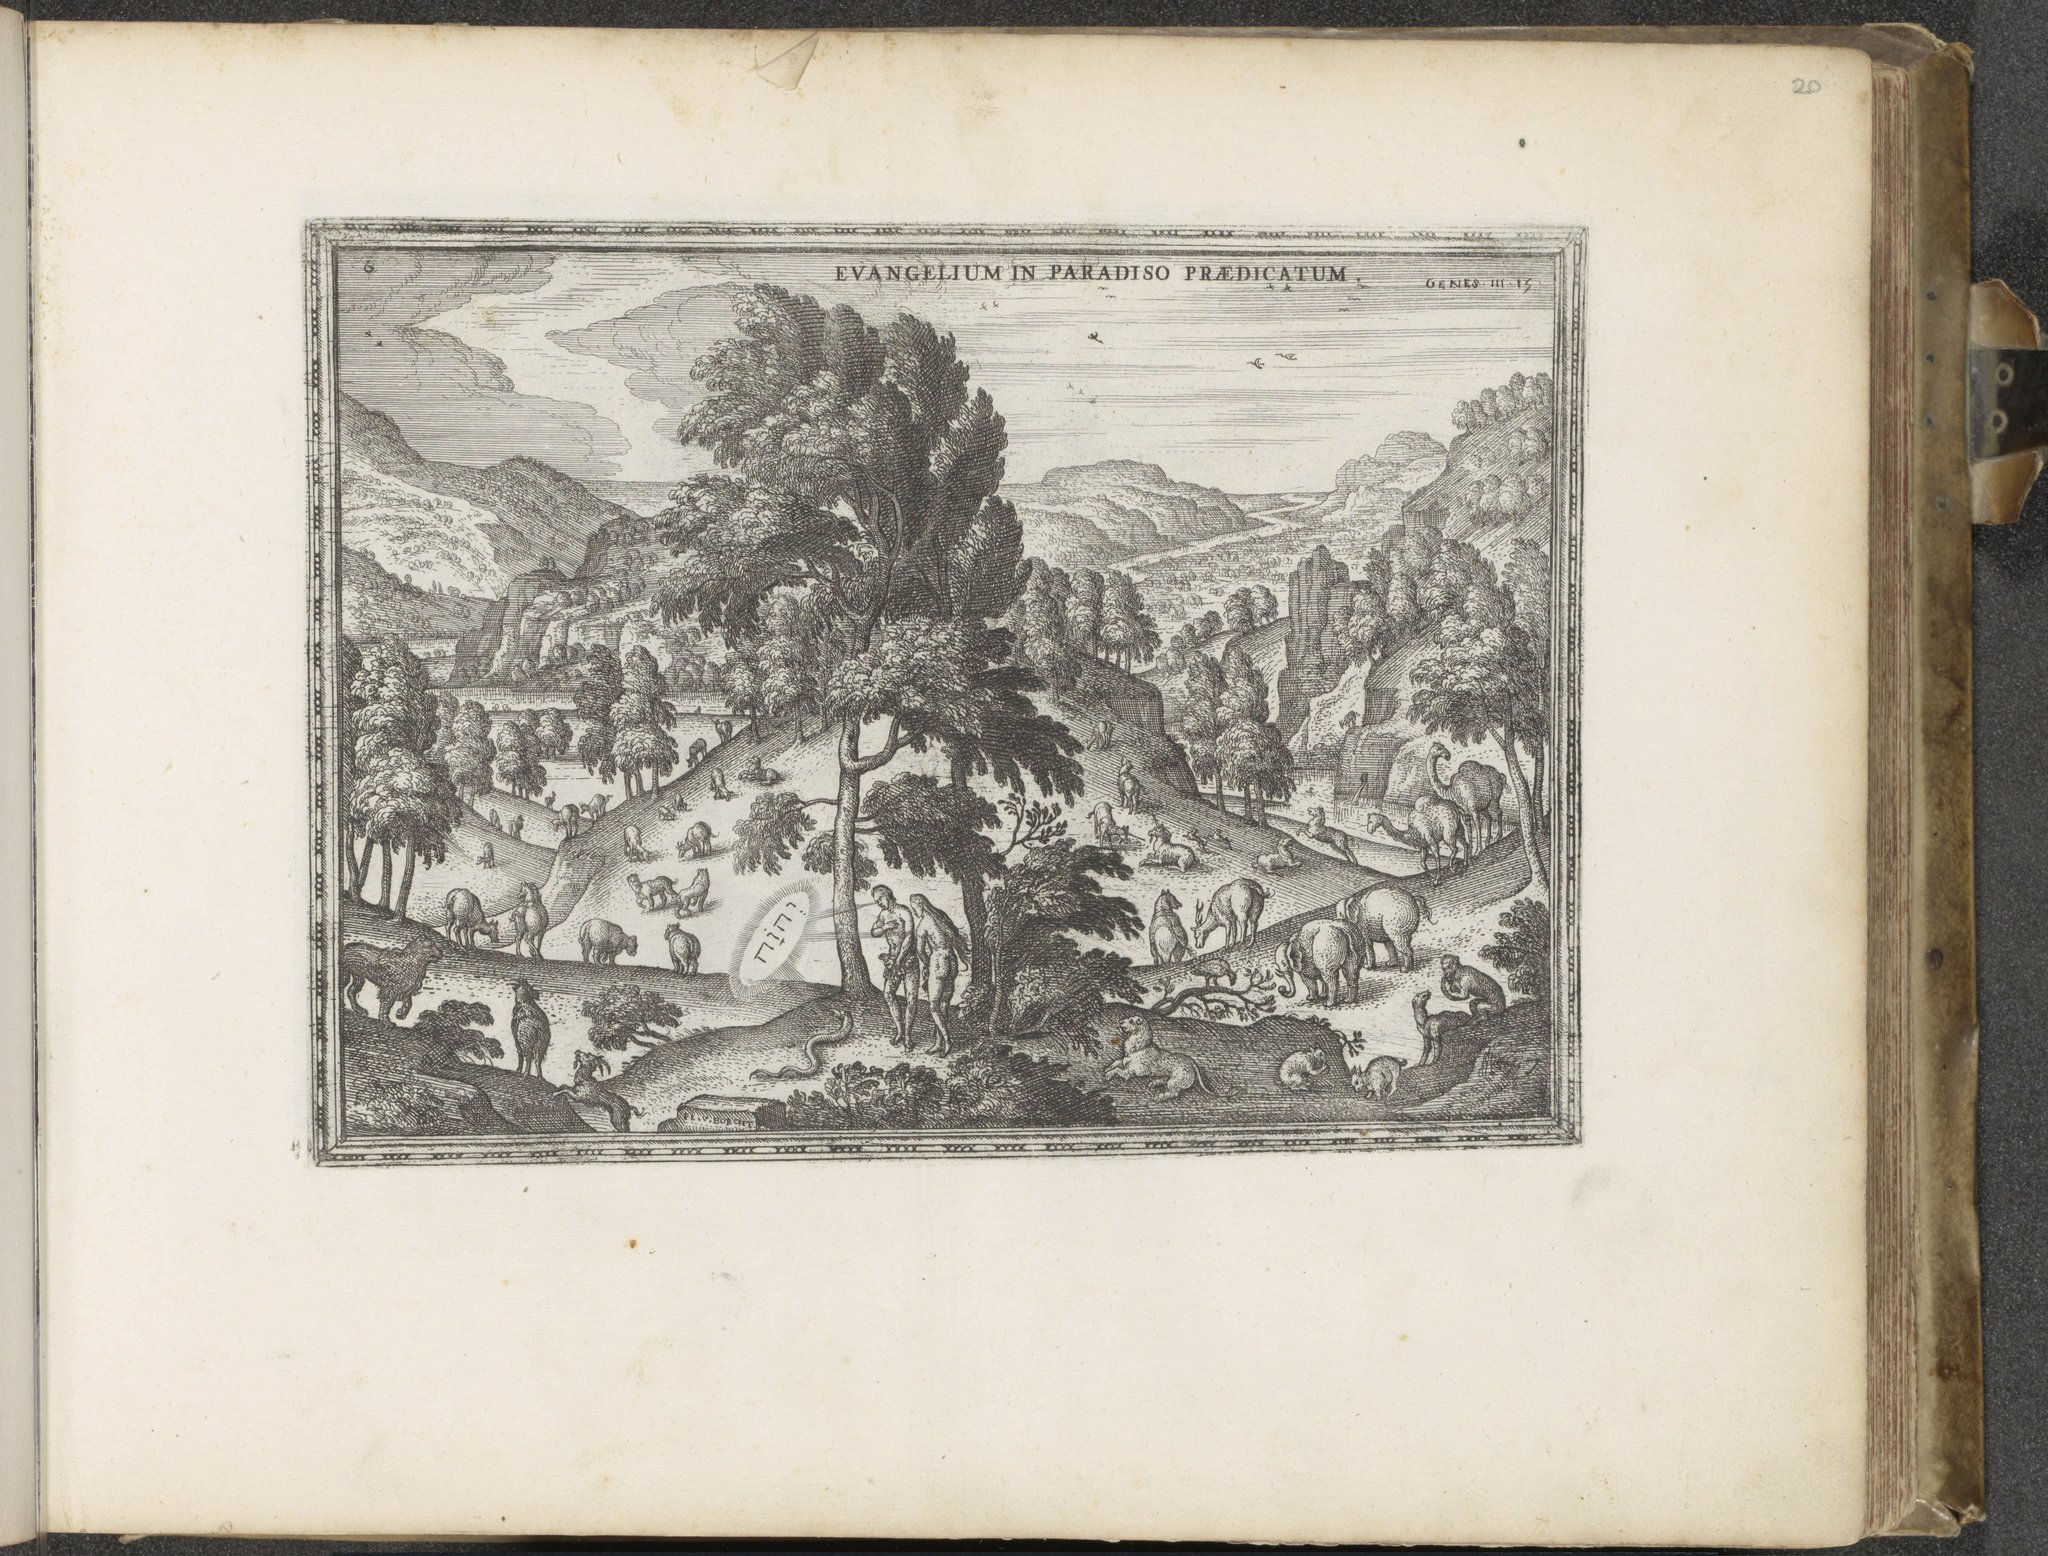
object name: album leaf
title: Den Grooten Emblemata Sacra, bestaande in meer dan vier hondert bybelsche figuren, zoo des Ouden als des Nieuwen Testaments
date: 1582-1593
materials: paper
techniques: etching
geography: amsterdam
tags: the snake is cursed by god, and condemned to eat dust and to crawl on its belly, animals, the tree of knowledge of good and evil (whose fruit, usually apples or figs, brings death); the tree may be guarded by the serpent, tetragram (in roman or hebrew script) ~ symbol of god the father, old testament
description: Te midden van de dieren en bij de boom der kennis van goed en kwaad vervloekt God de slang. Adam en Eva staan ernaast (Gen. 3:14). De prent maakt deel uit van een album.